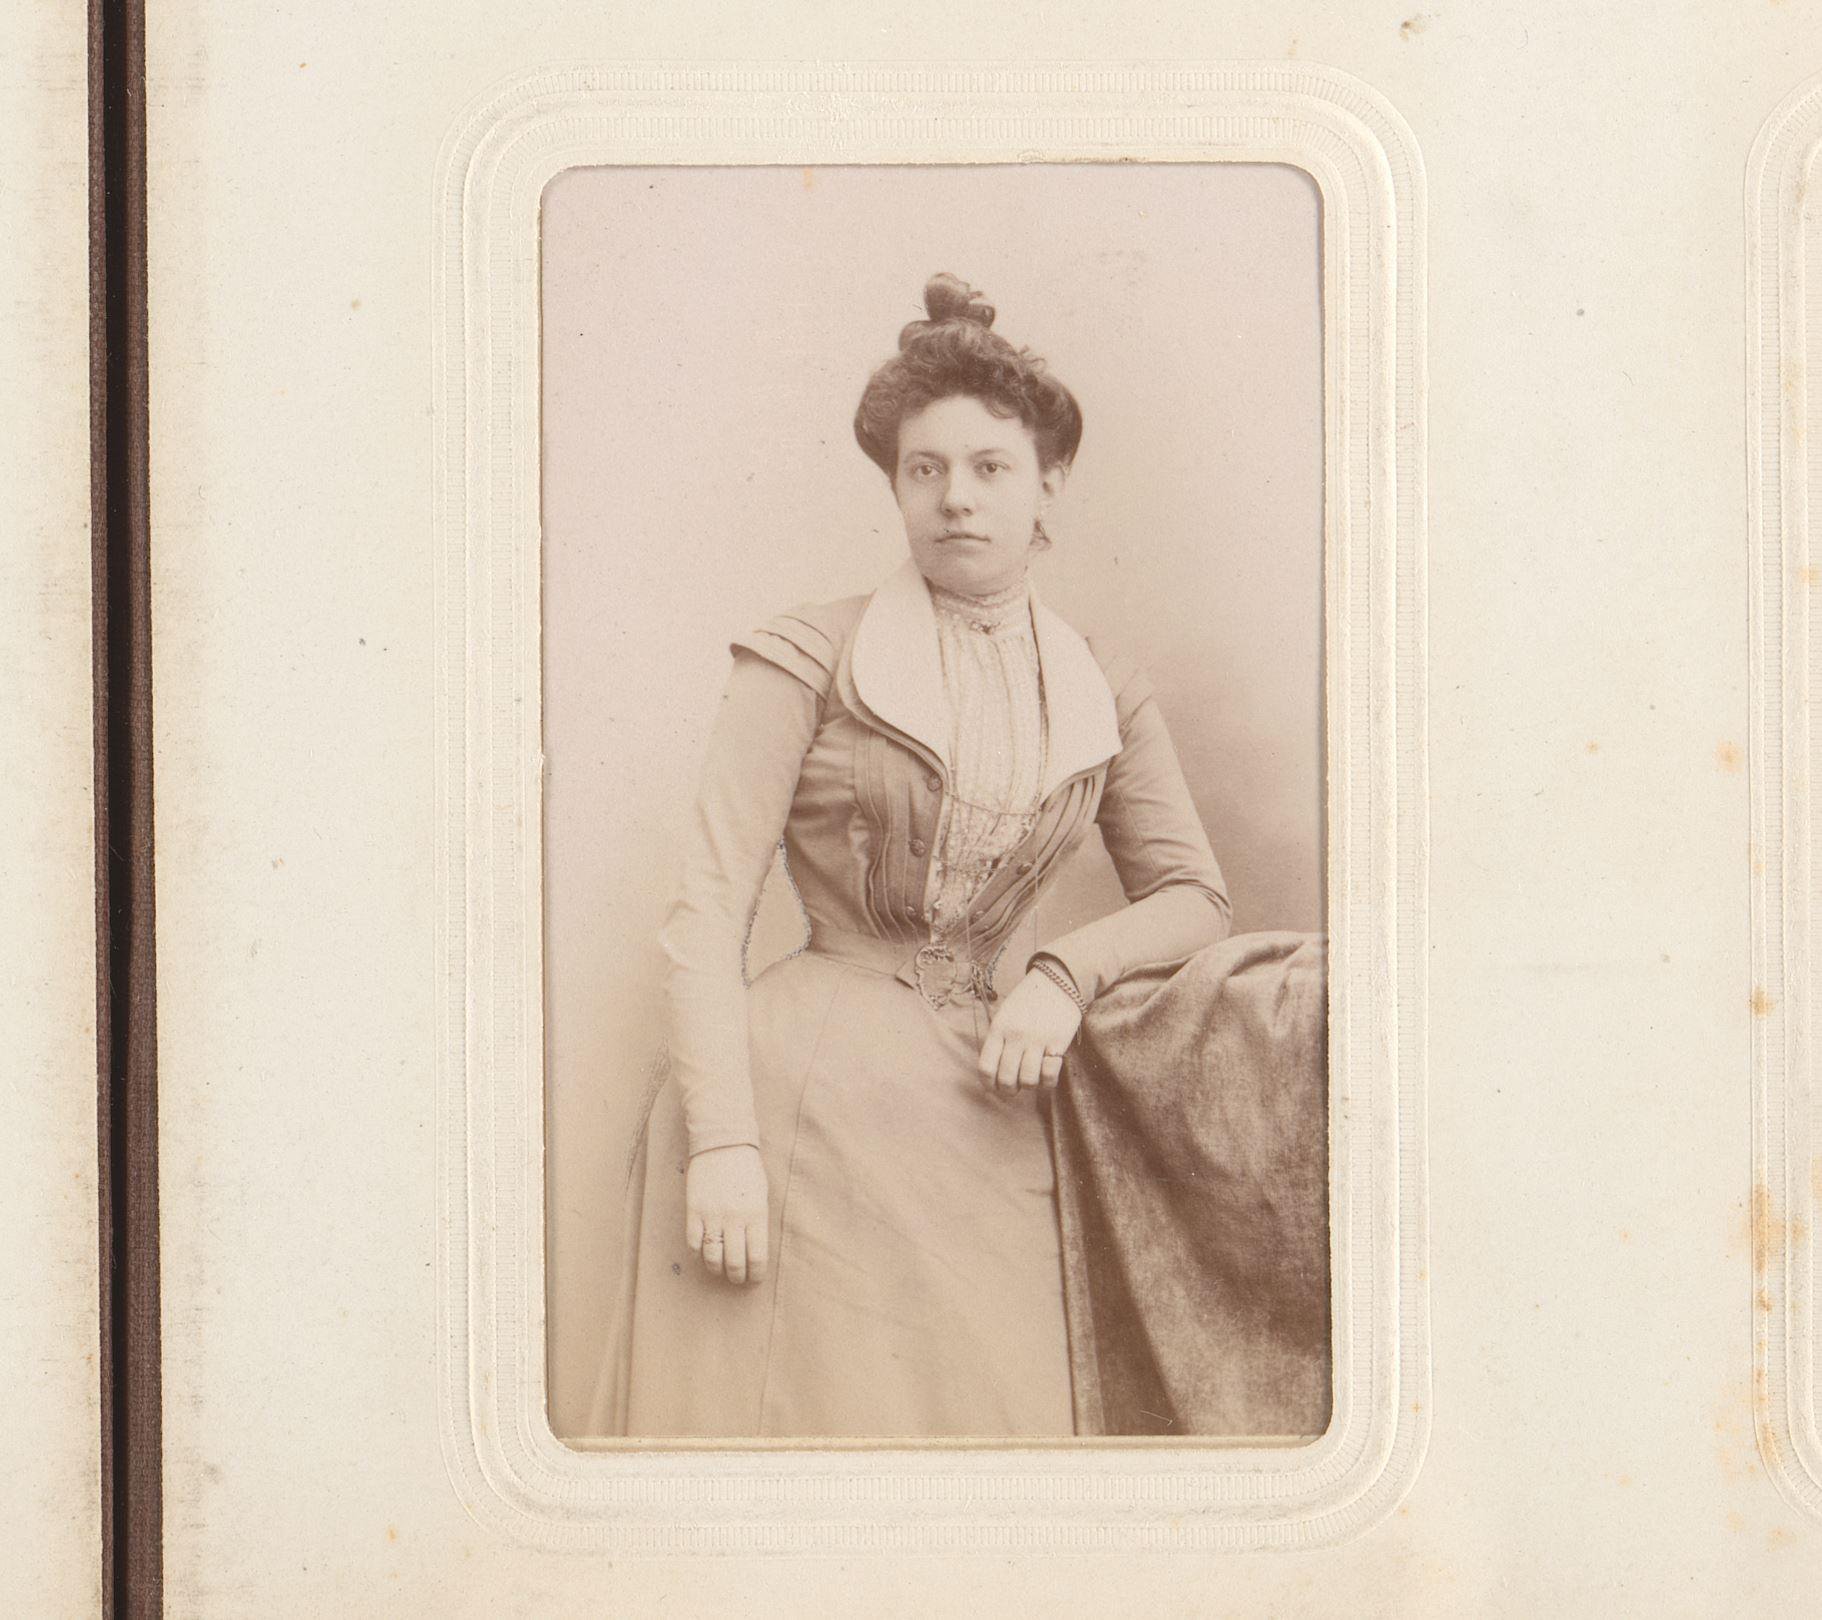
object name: album leaf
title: Portret van een vrouw, leunend op een sokkel waarover een doek gedrapeerd is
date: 1865-1900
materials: cardboard, paper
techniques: albumen print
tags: studio requisites ~ photographer, historical persons - bb - woman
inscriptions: inscription: ‘Ladrey Disderi/ 6 Bould. des Italiens, 6 PARIS’, inscription: ‘MÉDAILLES/ PARIS 1889/(...) 1896/ GRANDE/ PHOTOGRAPHIE/ Ladrey Disdéri/ 6, BD. DES ITALIENS, 6/ ANCIENNEMENT/ PASSAGE DES PRINCES/ PARIS/ REPRODUCTIONS/ AGRANDISSEMENTS/ par Procédés Inaltérables au Carbone/ Platine, Bromuer, etc./ Peintures à l'Huile, Pastels, Miniatures, etc/ Les Clichés/ sont Conservés,/ il suffit/ d'écrire./ PHOTOGRAPHE/ DE LA PRESIDENCE/ DU SÉNAT, DE LA CHAMBRE DES DEPUTÉS,/ du Corps Diplomatique, de l'Armée,/ DU CLERGE, DE LA MAGISTRATURE/ DE L'INSTITUT DE FRANCE, DES ÉCOLES POLYTECHNIQUE & ST CYR/ et de toutes les Ecoles spéciales/ PROCÉDÉ INSTANTANÉ POUR LES ENFANTS/ PAR TOUS LES TEMPS/ MAISON FONDÉE EN 1840/ DECHAVINES PARIS’